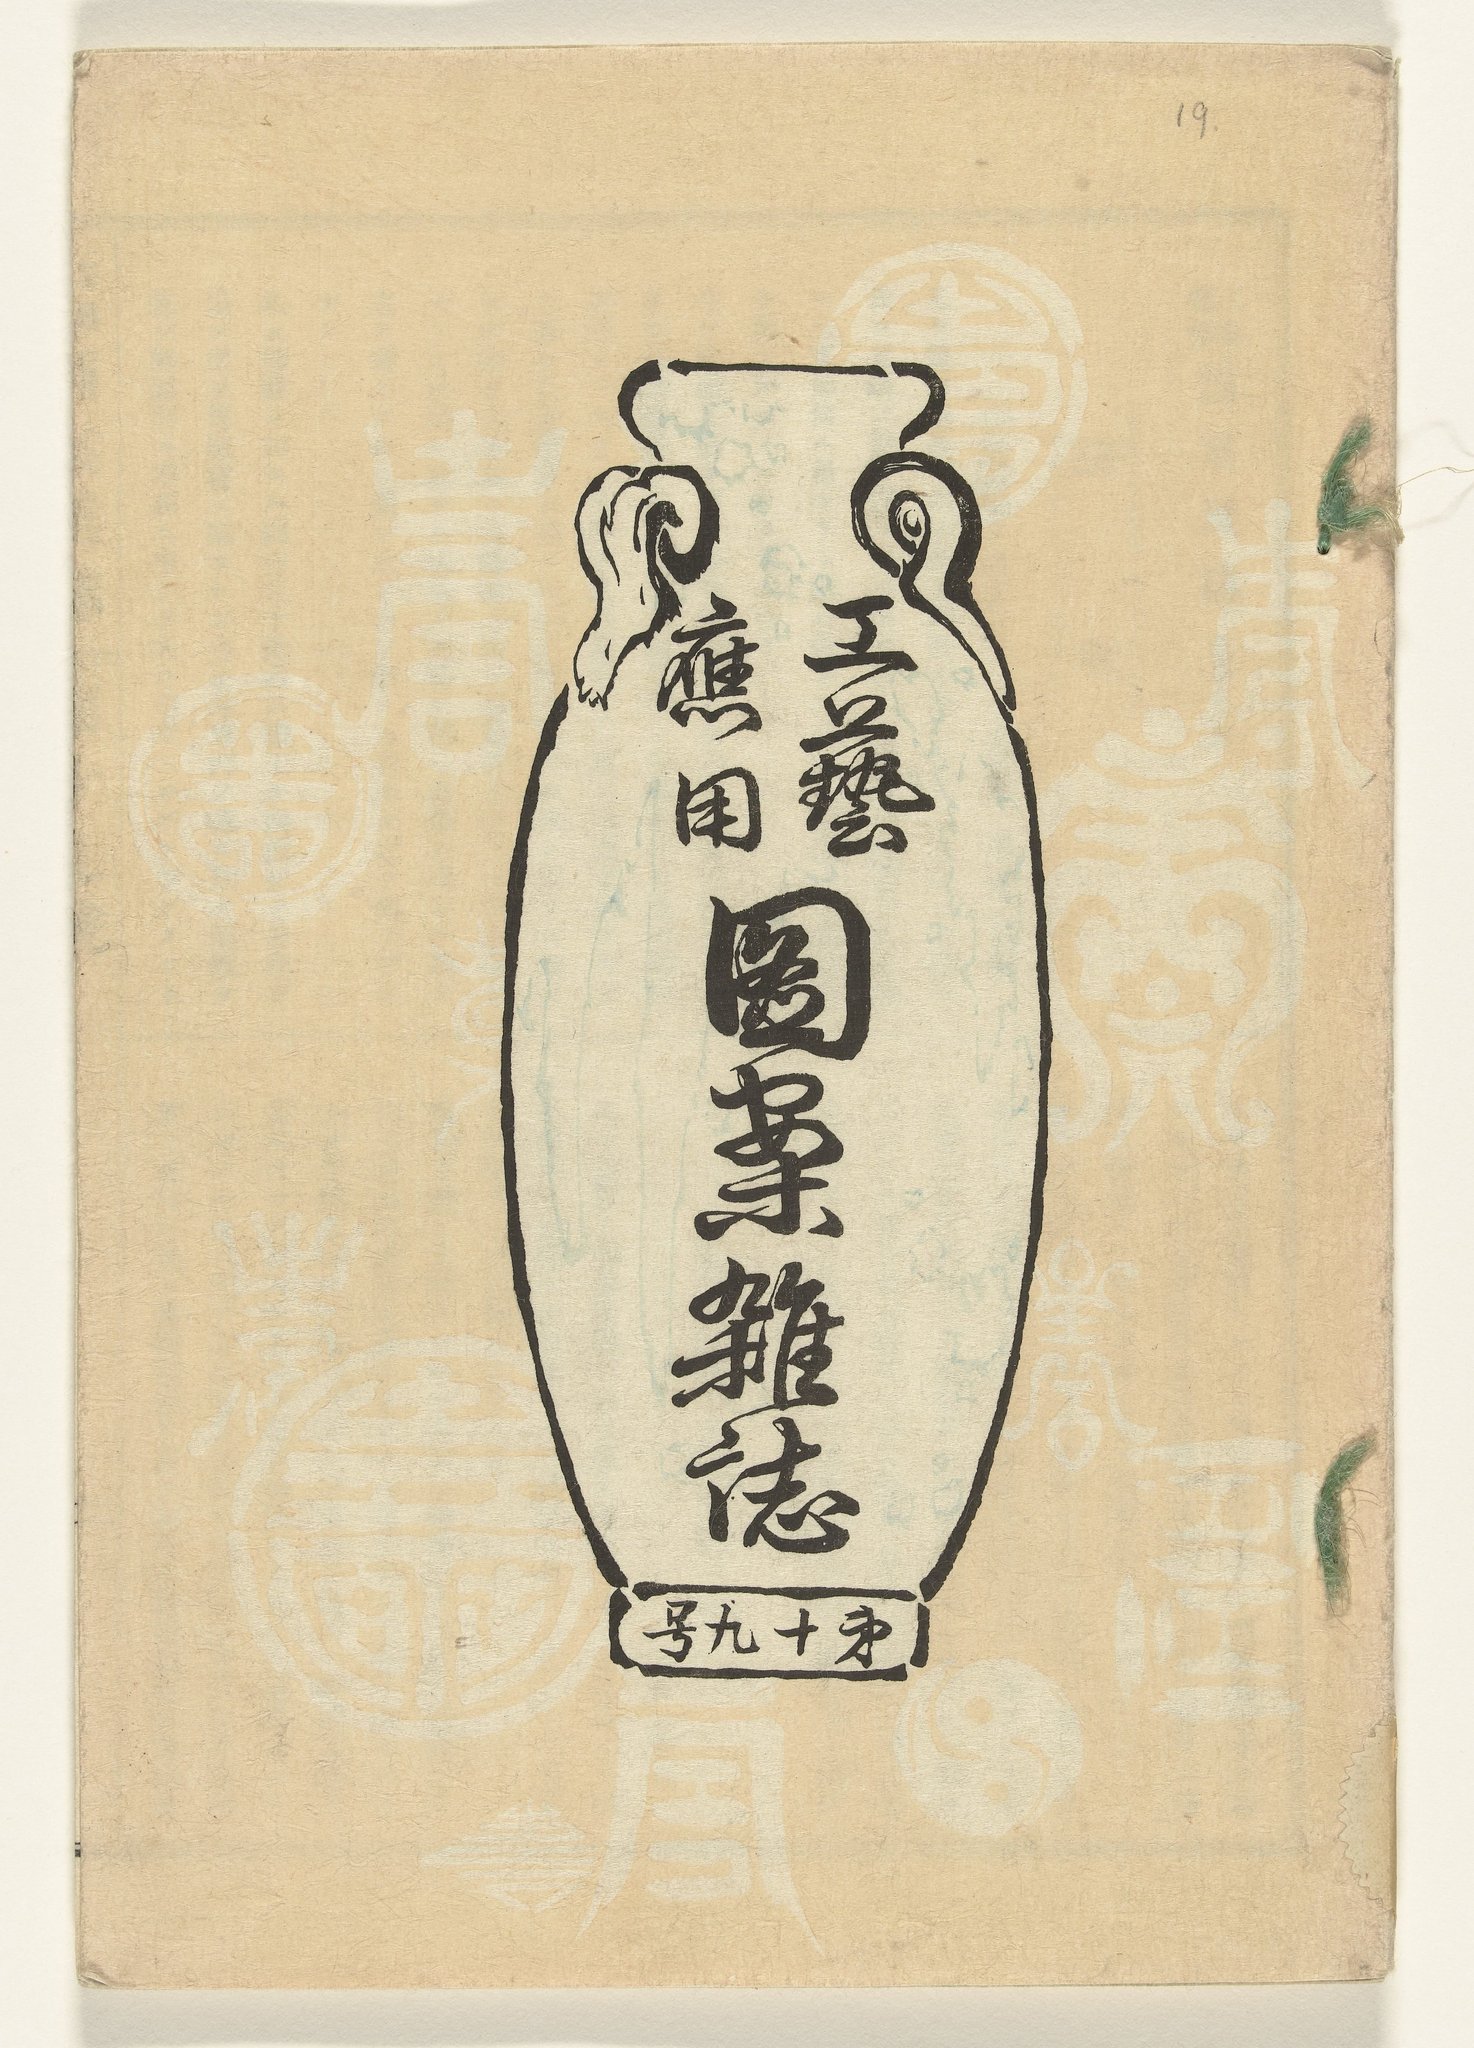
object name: magazine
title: Ontwerpen voor toegepaste kunst- deel negentien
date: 1810-1893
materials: paper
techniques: woodcut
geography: tokyo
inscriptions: collector's mark: ‘Rijksschool voor kunstnijverheid’ Lugt 3937